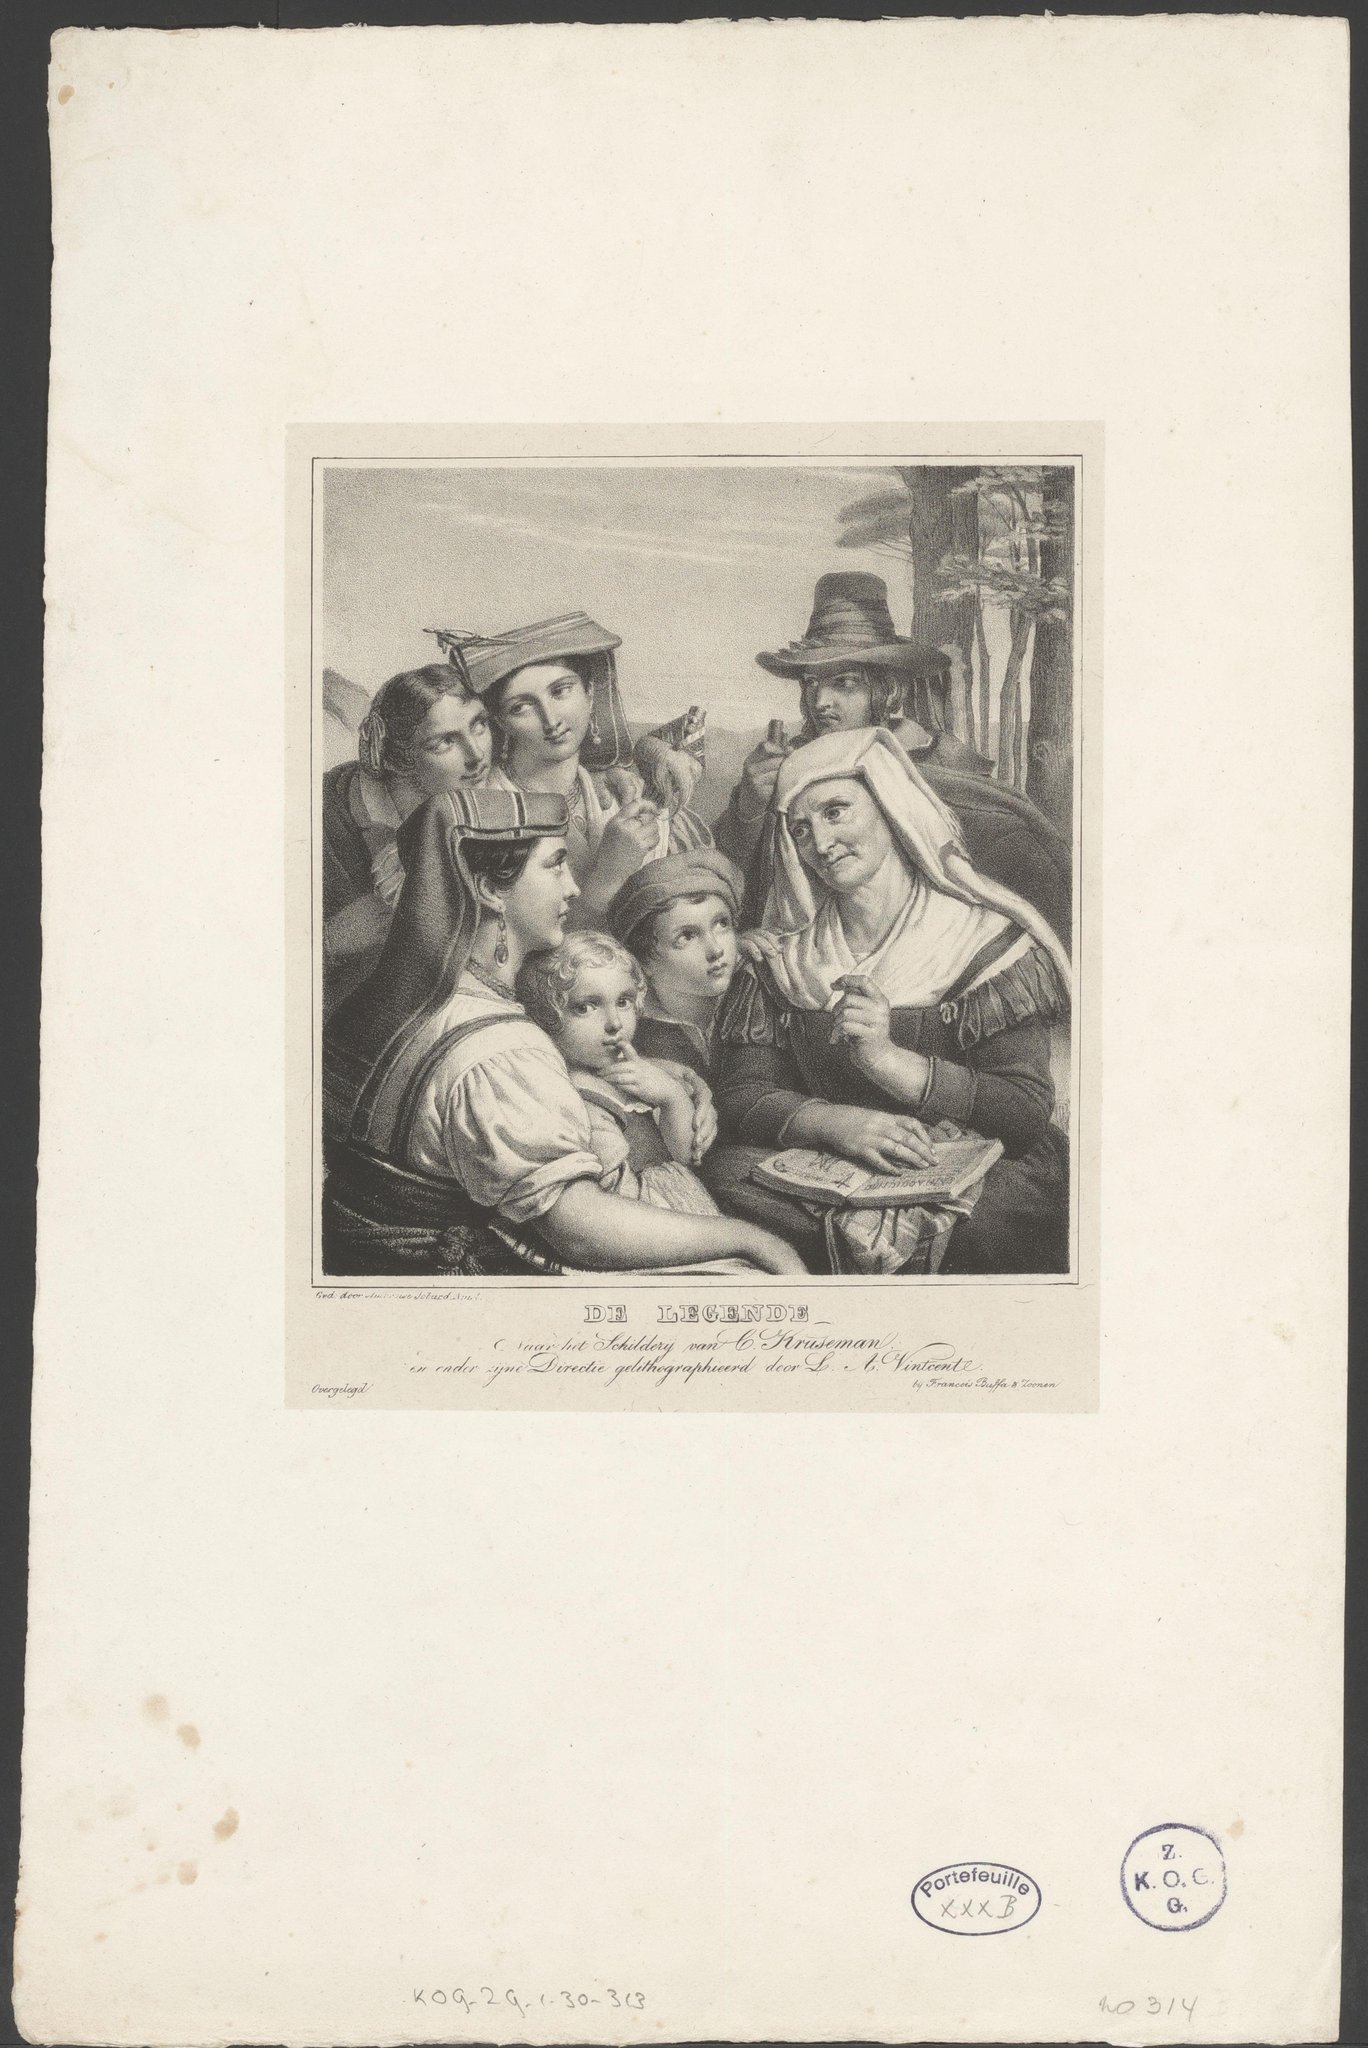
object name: print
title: Oude vrouw vertel een verhaal aan een groep jonge mensen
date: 1827-1828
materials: paper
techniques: lithograph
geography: amsterdam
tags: story teller; listening to story teller, adolescent, young woman, maiden, child, book - mm - book open, old woman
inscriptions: collector's mark: Lugt 1641, stamp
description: Onderwerpsrubrieken binnen de Atlas Zeden en Gewoonten: Zeden en Gewoonten in engeren zin. Volksleven. Zinnebeeldige voorstellingen uit het volkleven op serieprenten. Maanden en diversen (allegorieën).